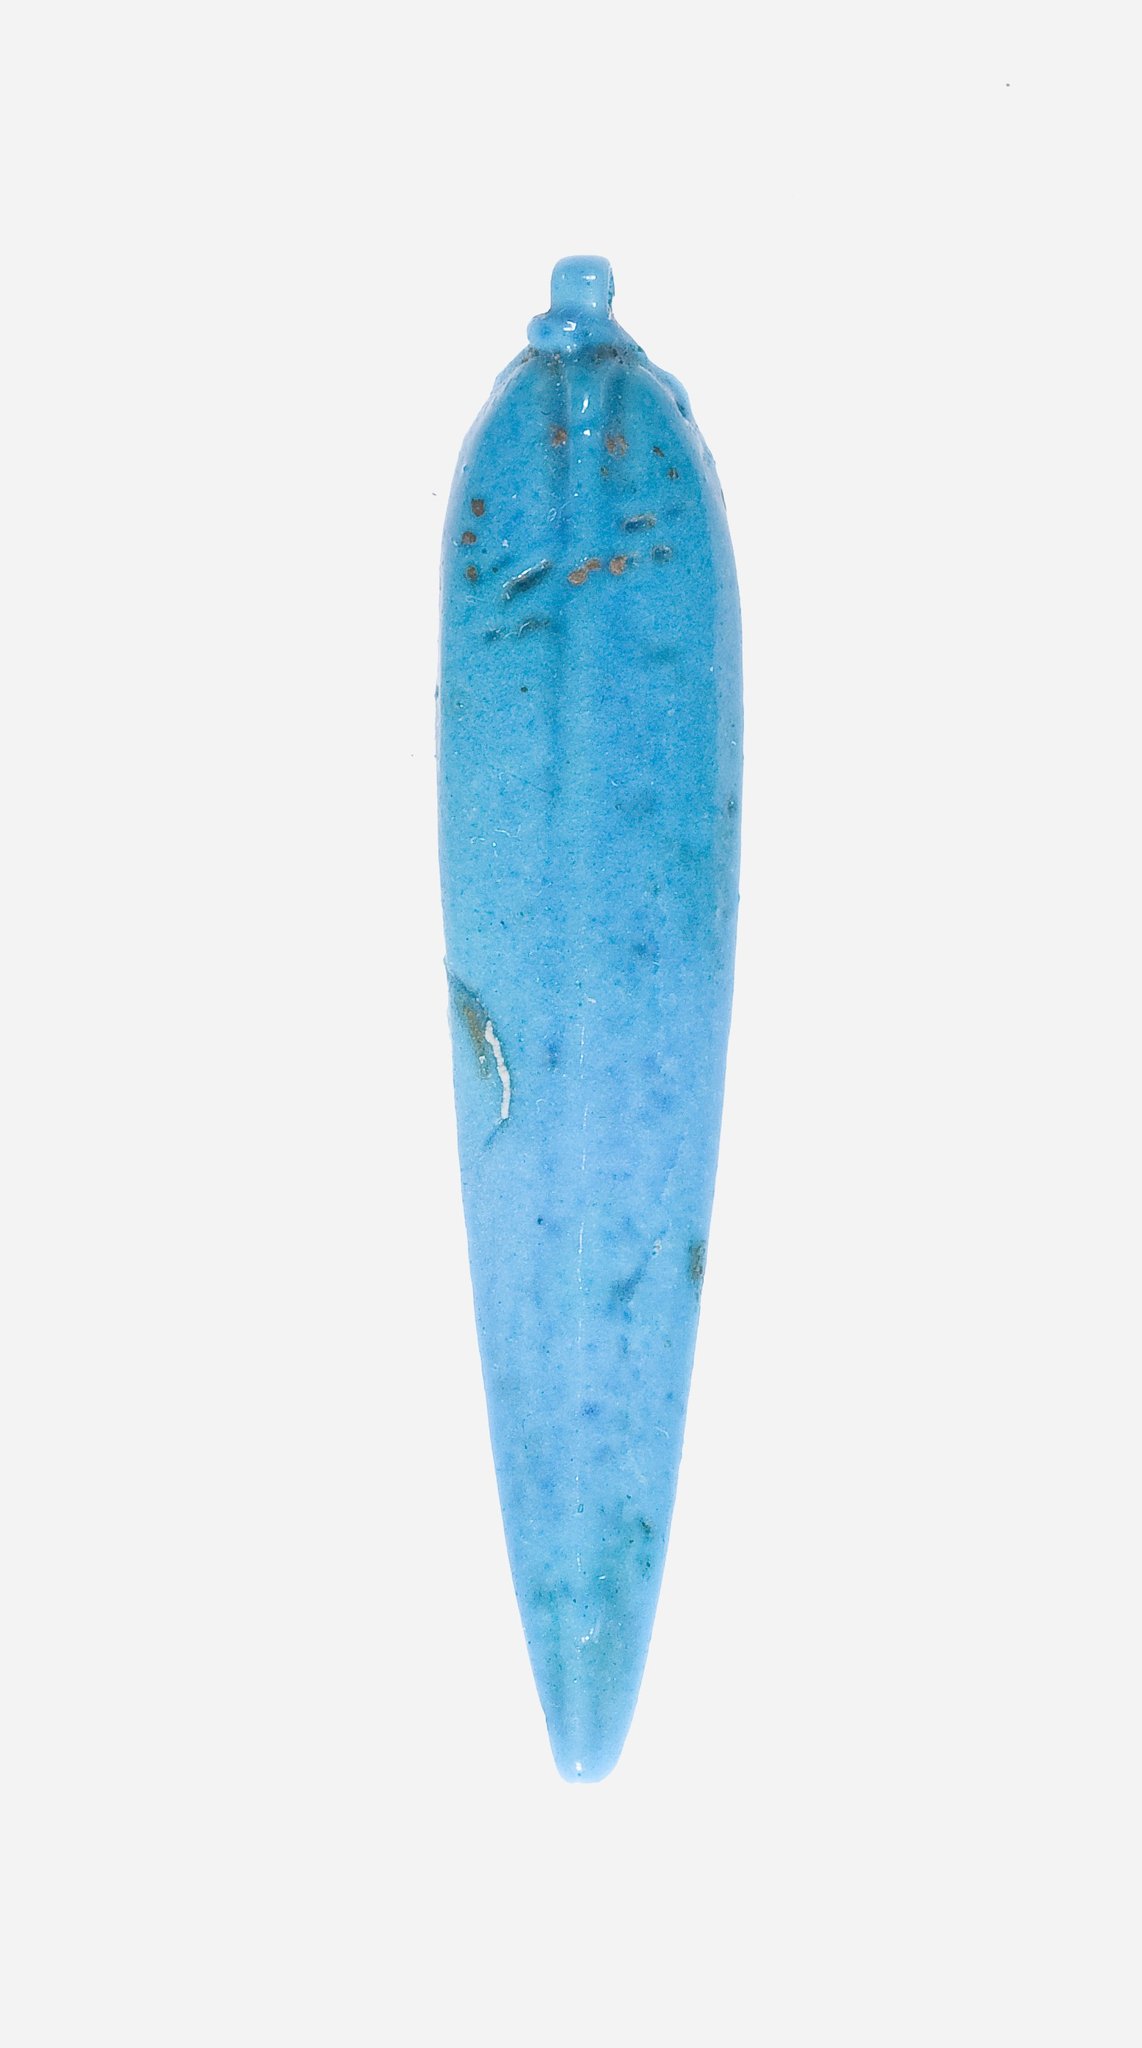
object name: bead, lotus petal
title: Blue Lotus Petal Bead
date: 1390-1352 BCE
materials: faience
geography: egypt